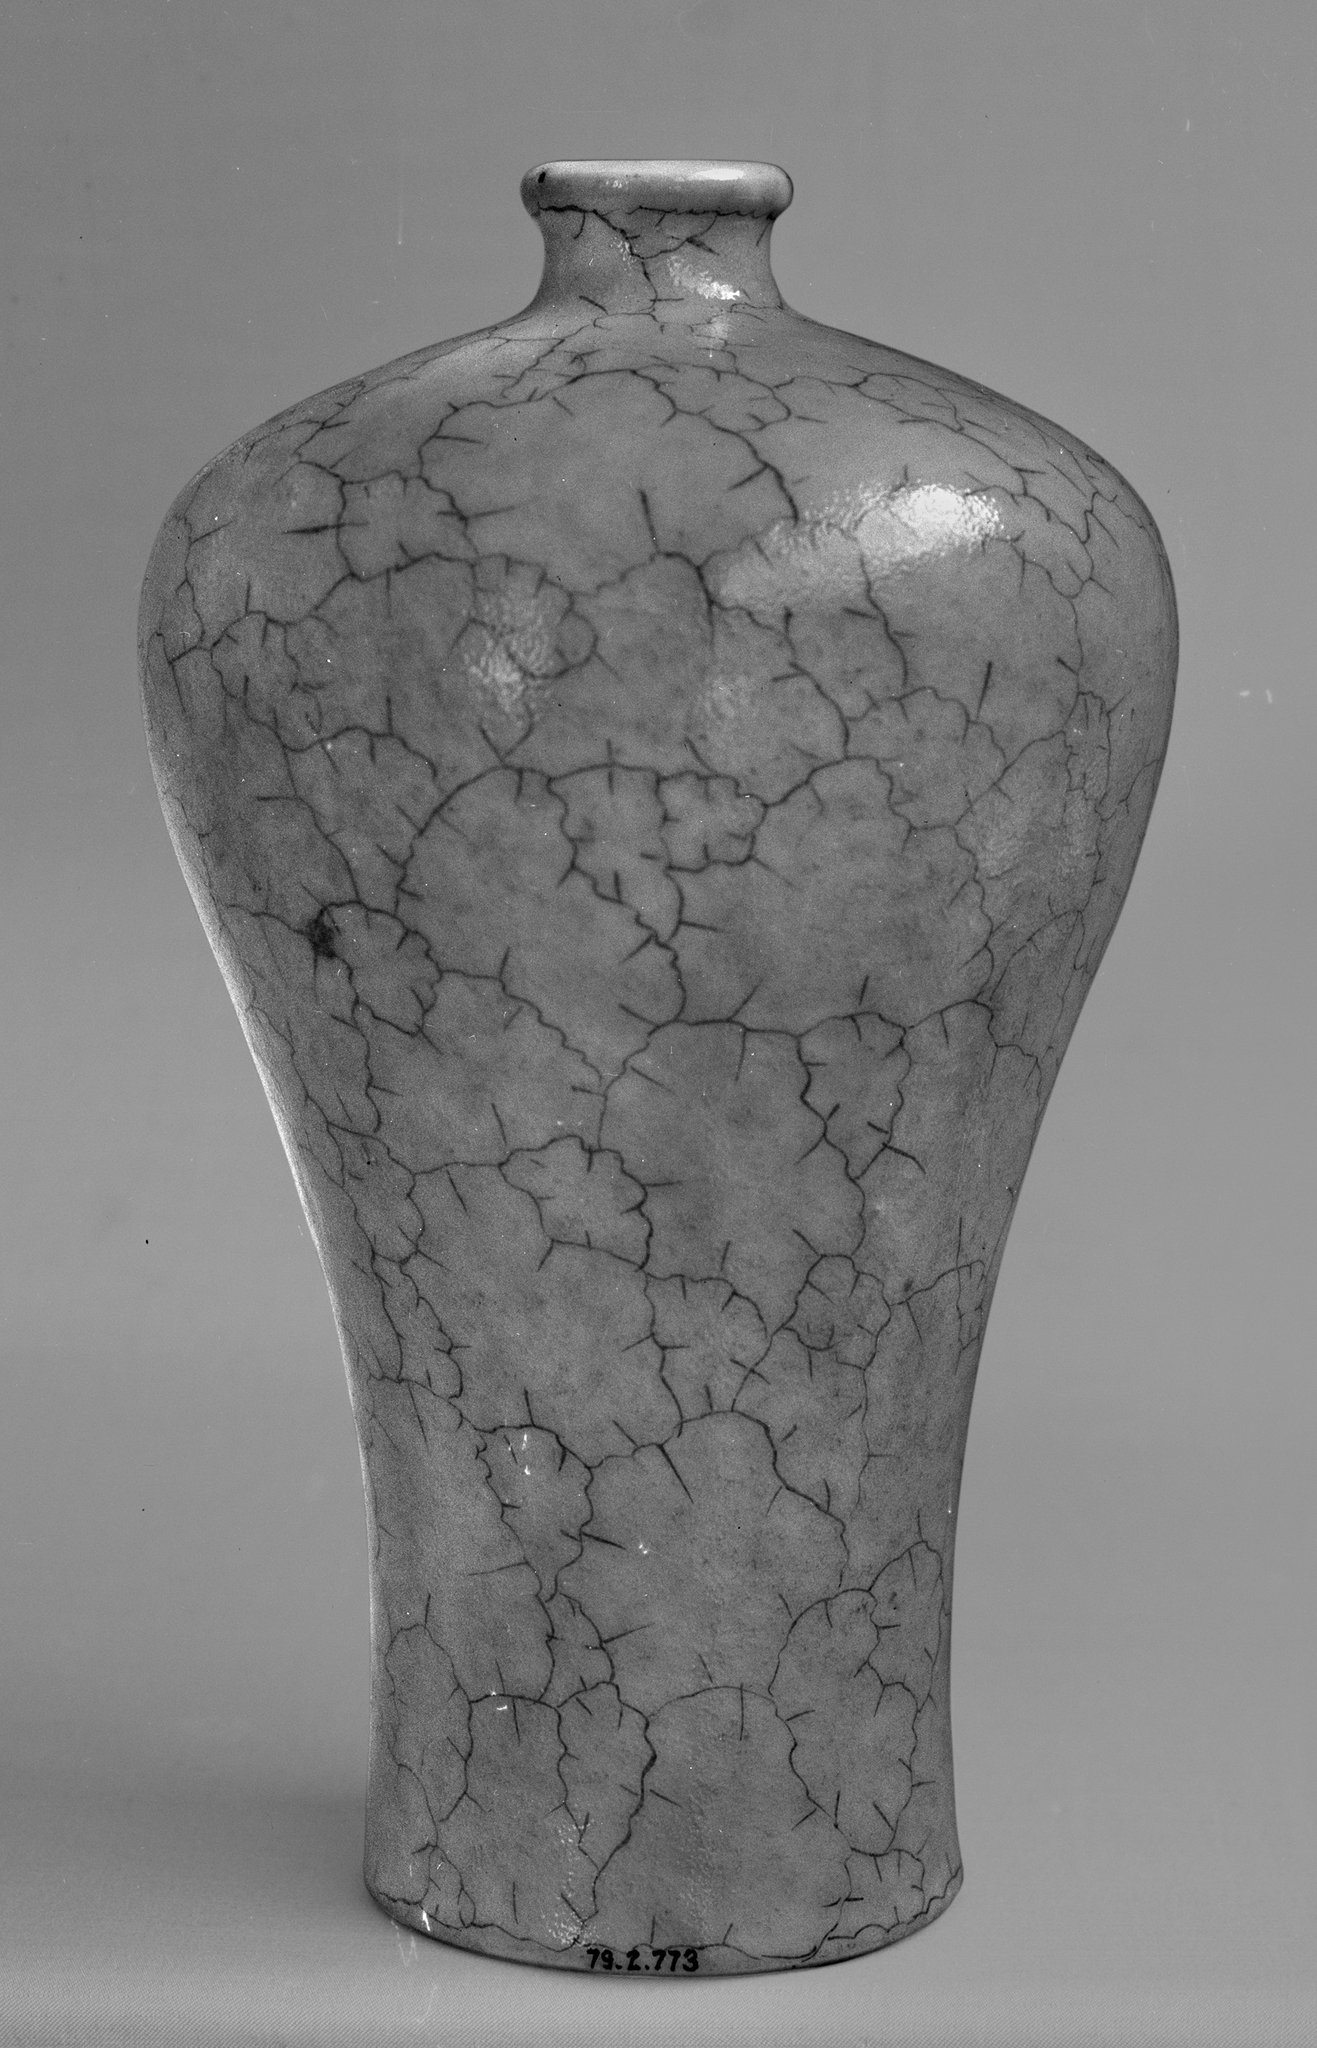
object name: vase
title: Meiping vase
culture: chinese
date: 1701-1800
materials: glaze, porcelain